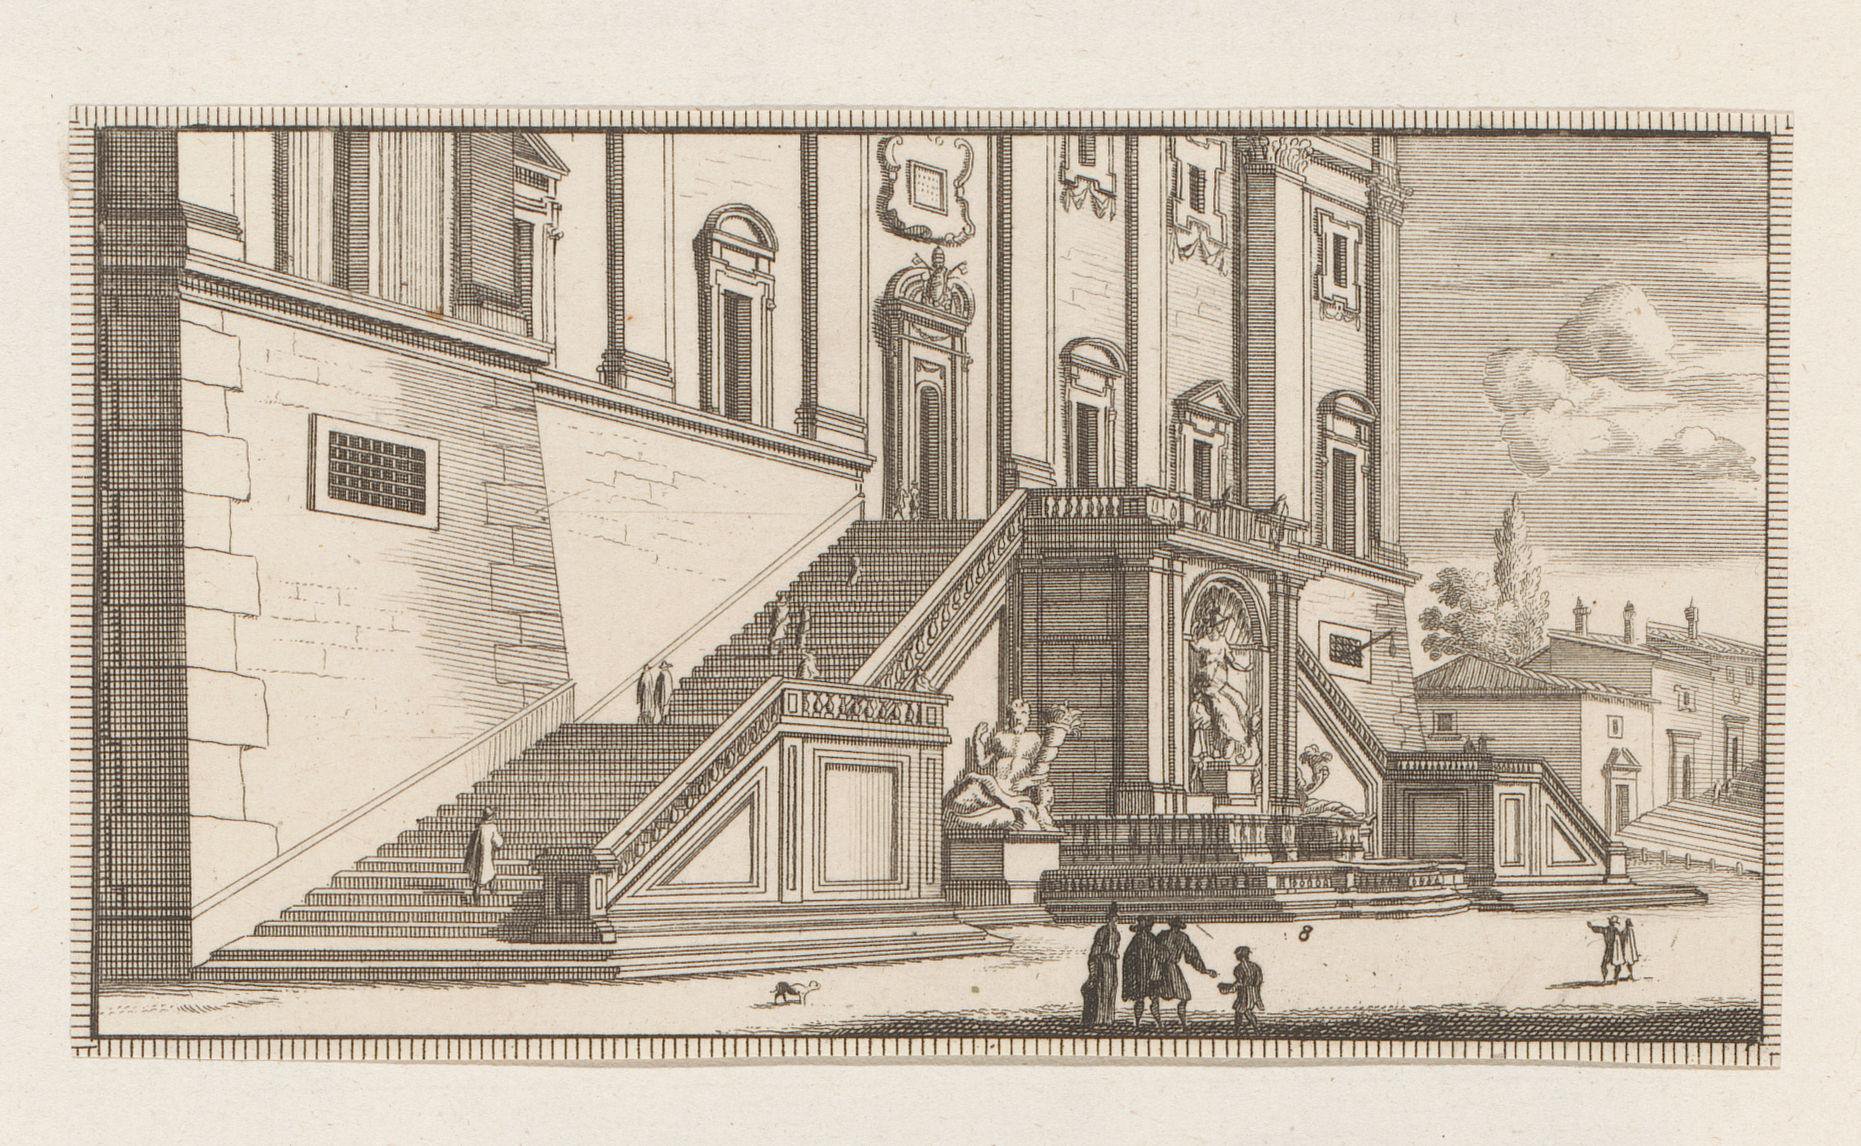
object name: album leaf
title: Magesyn der Italiaense gebouwen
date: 1729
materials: paper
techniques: etching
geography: amsterdam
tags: square, place, circus, etc., ornamental fountain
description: Gezicht op de Fontana della Dea op het Capitool te Rome. De prent maakt deel uit van een album.